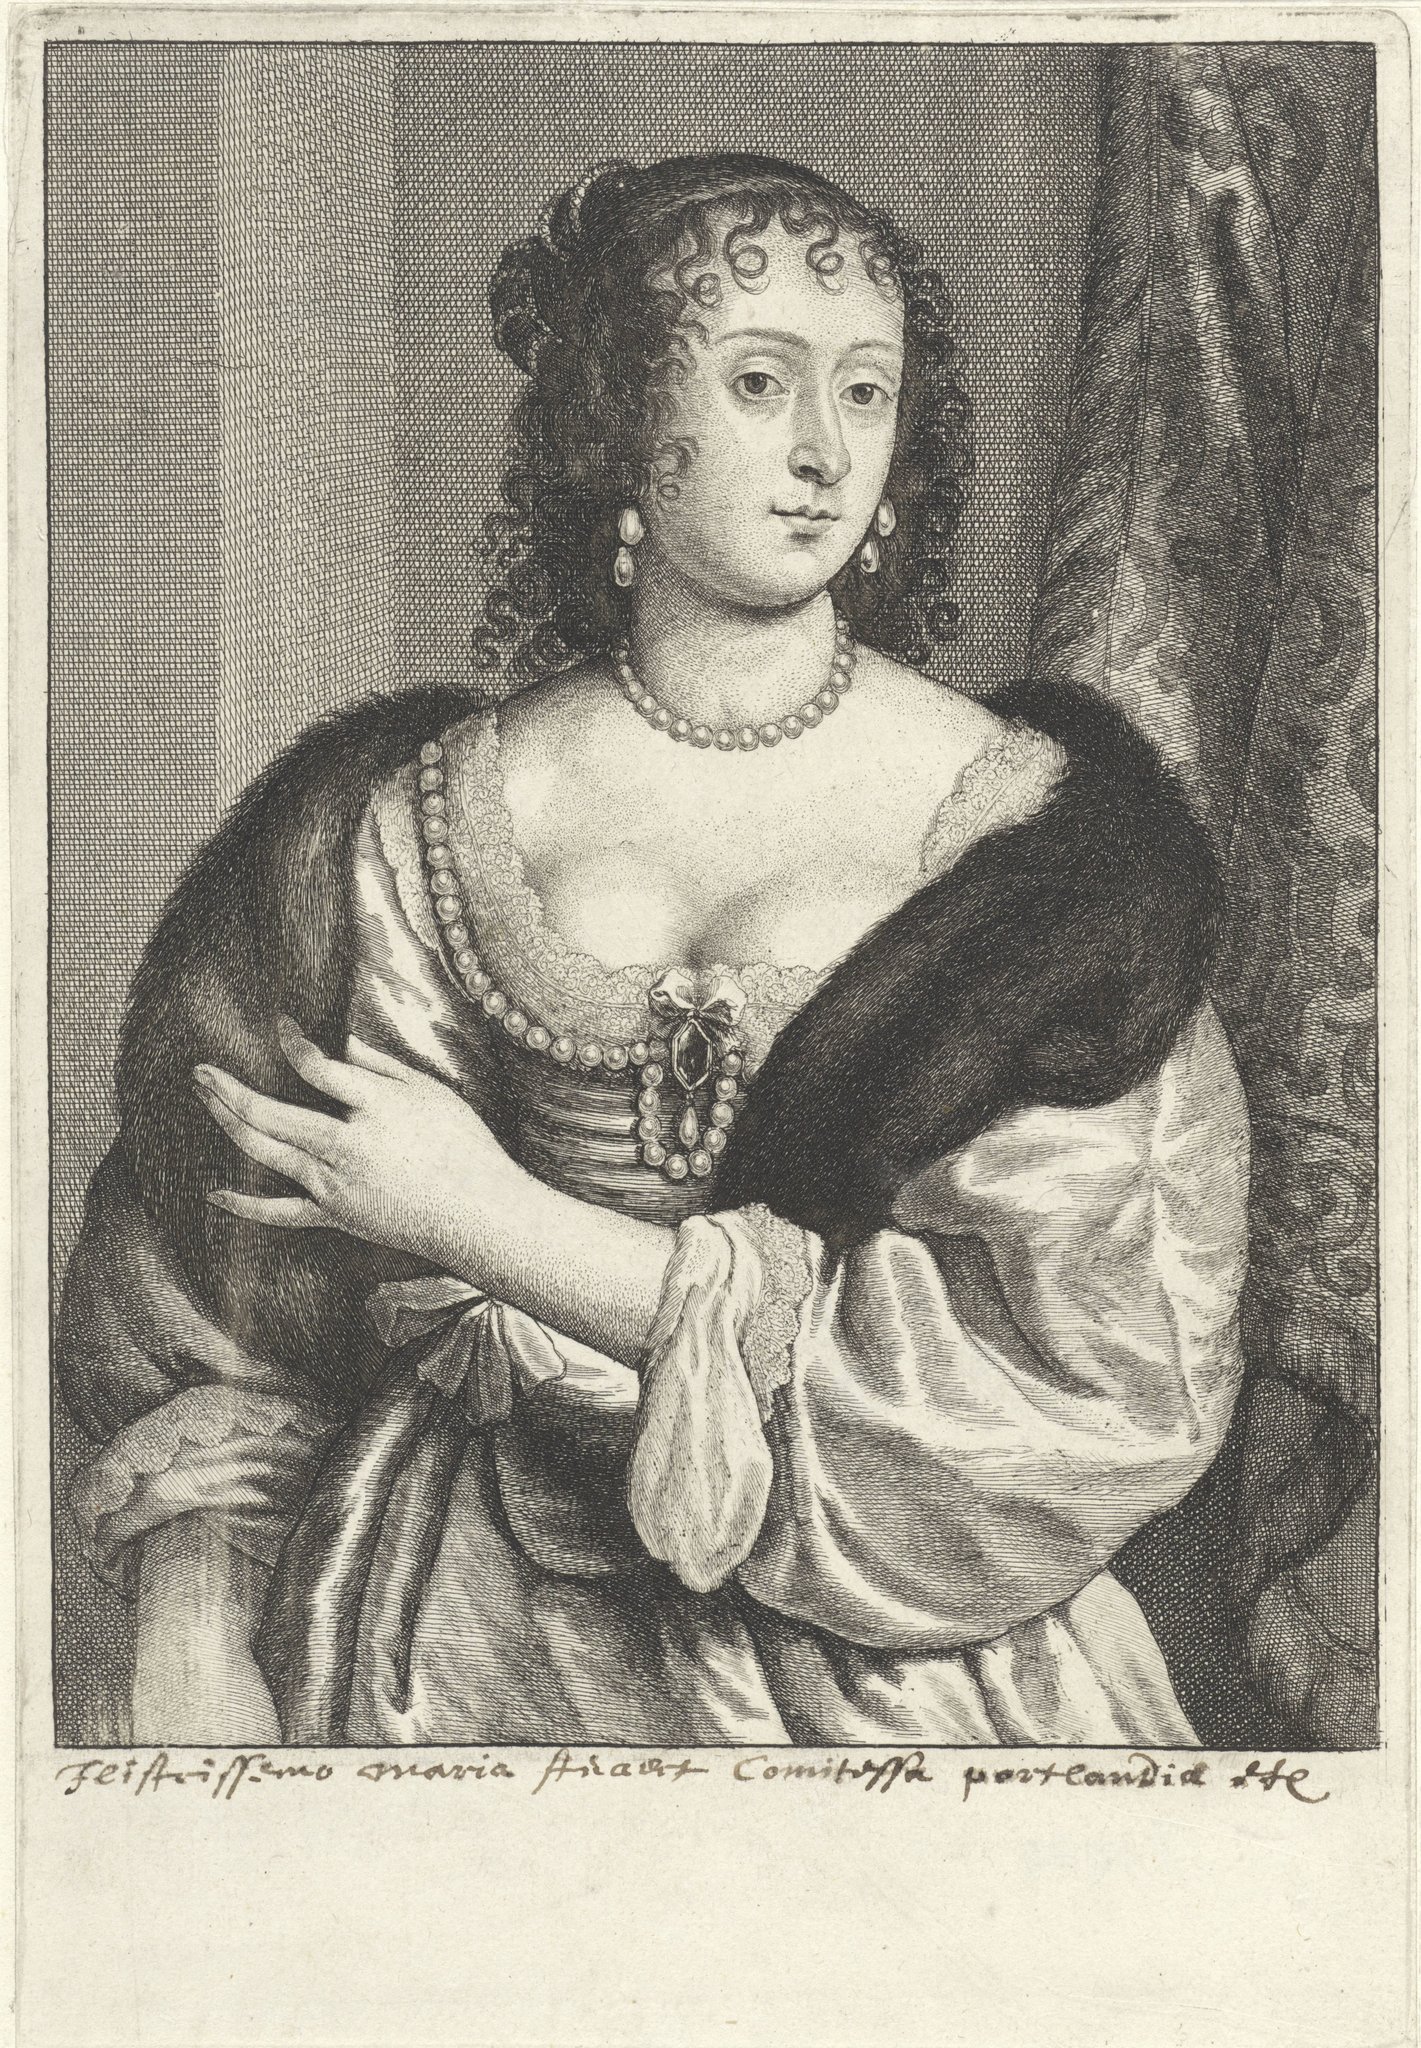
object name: print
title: Portretten naar Anthony van Dyck door Joannes Meyssens uitgegeven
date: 1650-1670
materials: paper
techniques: etching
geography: antwerp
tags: frances stuart (gravin van portland)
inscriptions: collector's mark: Lugt 240, inscription: ‘[...] Maria Stuart Comitissa Portlandiae’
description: De prent maakt deel uit van een zevendelige serie portretten naar Anthony van Dyck, uitgegeven door Joannes Meyssens.